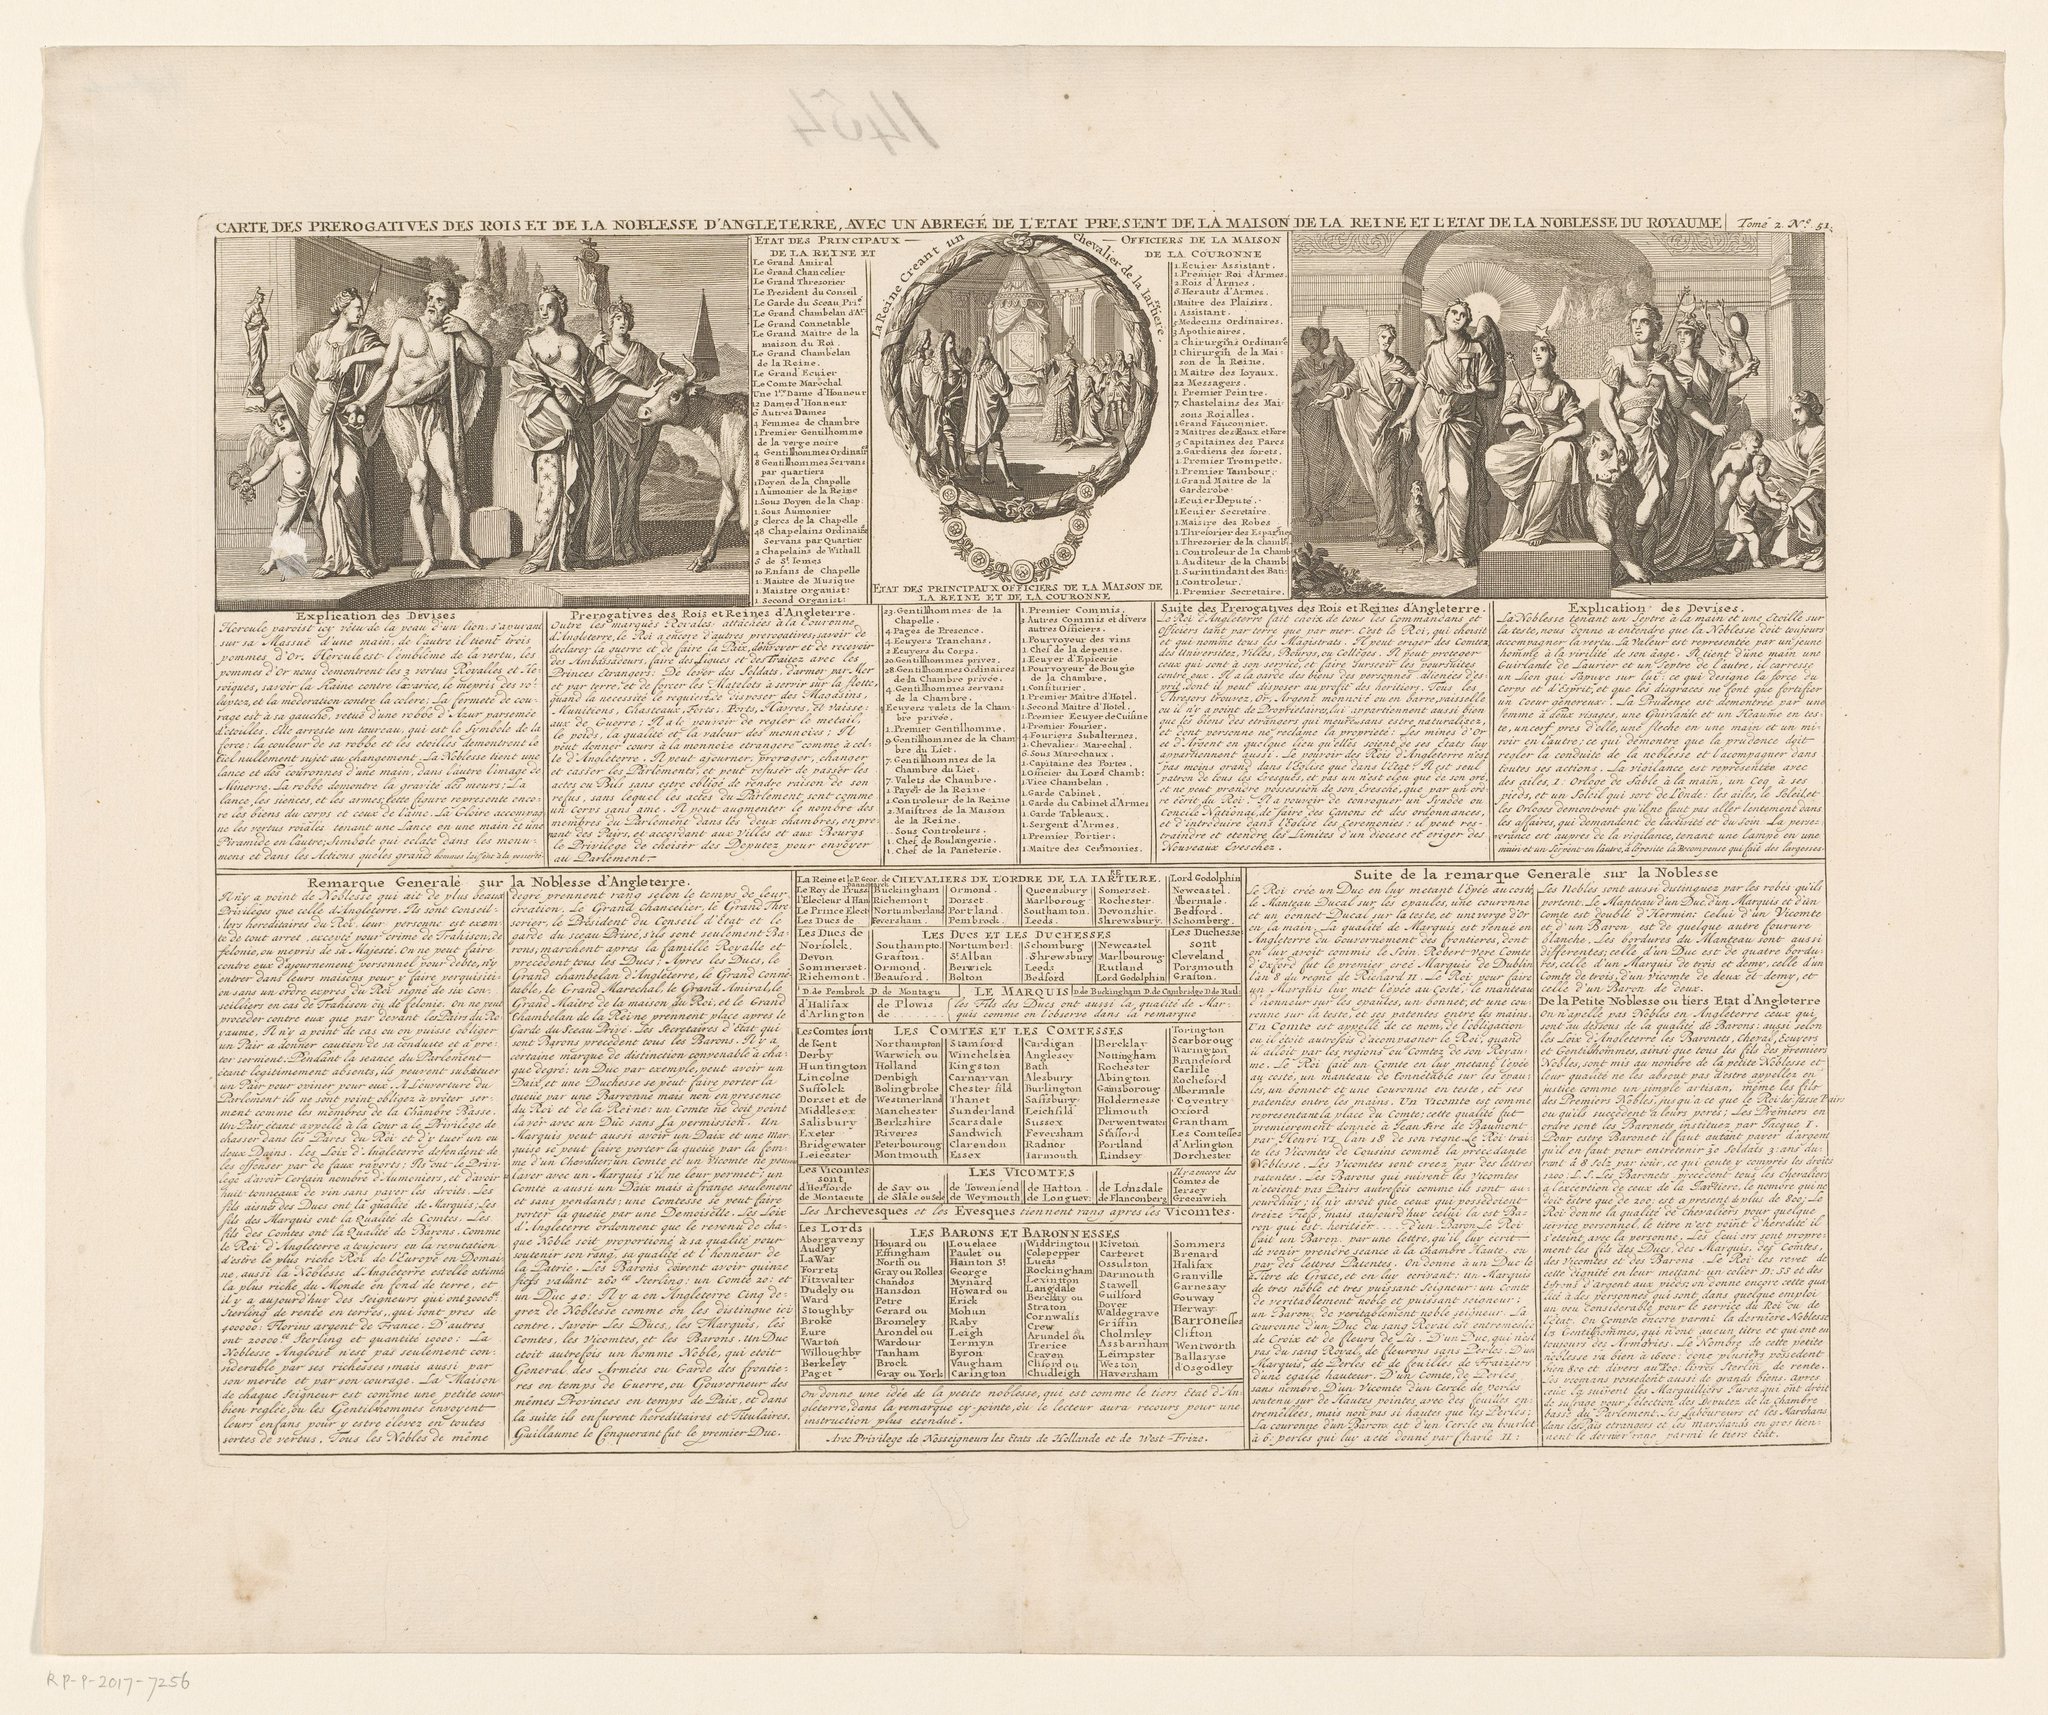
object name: print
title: Privileges van Engelse koningen en adel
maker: Anonymous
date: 1706-1708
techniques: engraving, etching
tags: knighting ceremonies, knighthood order (garter), england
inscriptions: collector's mark: Lugt 2228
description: Blad met drie voorstellingen en tekst over de privileges van de Engelse koningen en adel. Links en rechts allegorische voorstellingen. In het midden een voorstelling van de koningin die een ridder van de Orde van de Kousenband benoemt.